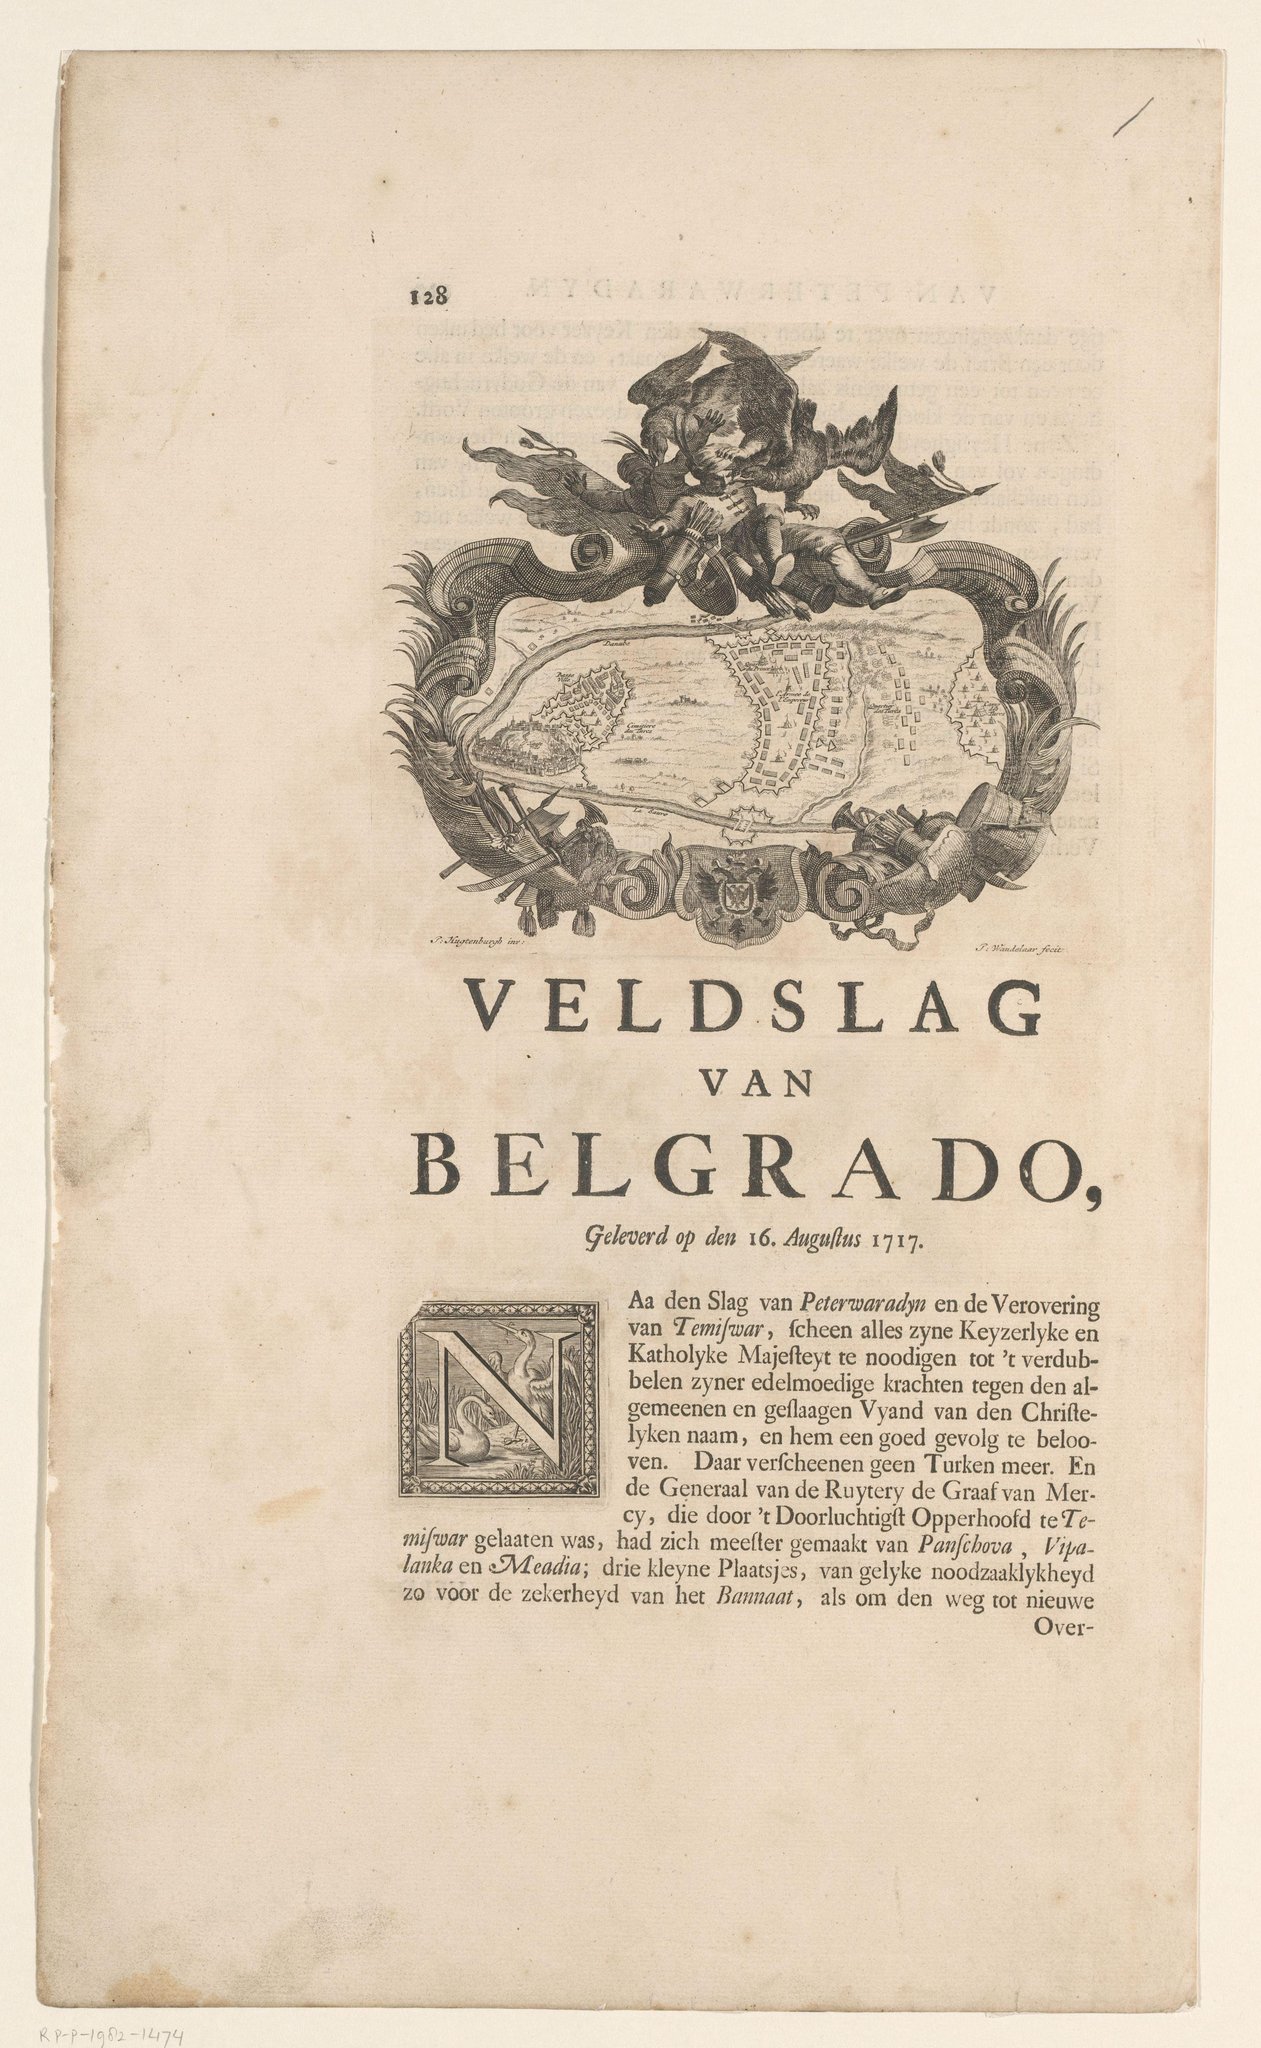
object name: book illustration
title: Inname van Belgrado, 1717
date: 1729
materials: paper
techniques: etching, letterpress printing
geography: northern netherlands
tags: paris, vienna, eugenius van savoye, battle (+ land forces), plan of battle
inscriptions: collector's mark: Lugt 2228, collector's mark: Lugt 2760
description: Blad bedrukt met tekst op beide zijden, een gegraveerde initiaal H en een cartouche met een voorstelling van de veldslag bij de verovering van de stad Belgrado door de keizerlijke troepen onder de prins van Savoye op de Turken, 16 augustus 1717. Op de achterzijde een vignet met de drie furieën (Bernard Picart 1727). Blad (Pag. 127-128) uit het eerste deel van: Jean du Mont, Oorlogskundige beschryving van de veldslagen en belegeringen, der drie ... wydvermaarde krygsoversten... den Prins Eugenius van Savoye, den ... Hertog van Marlborough, en den Prins van Oranje en Nassau-Vriesland, in de editie van 1729. Dit eerste deel is gewijd aan de daden van Eugenius, prins van Savoye.